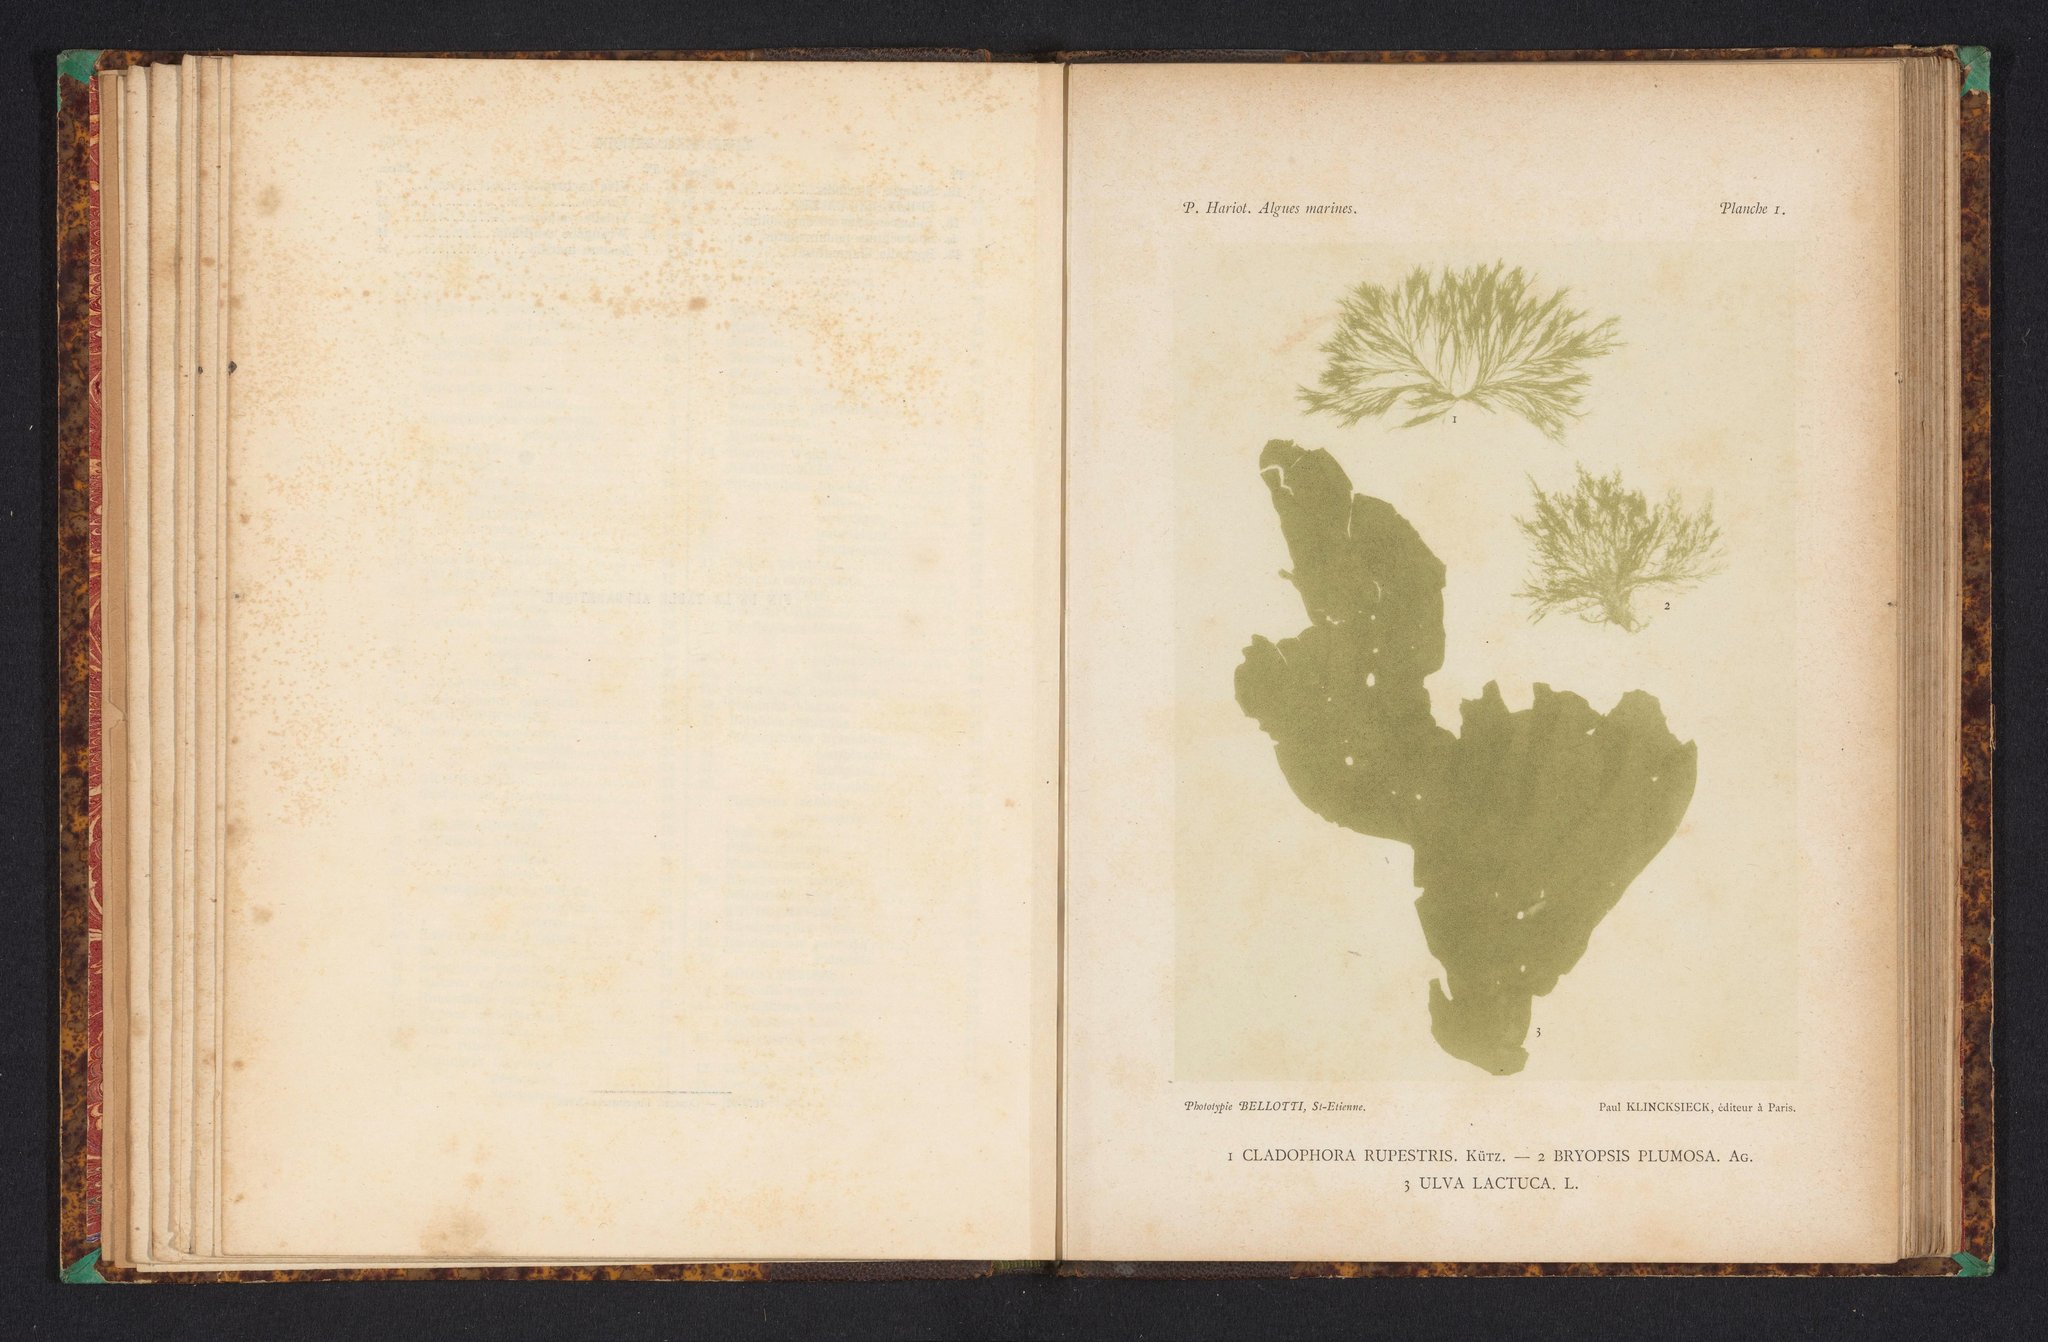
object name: page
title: Drie soorten zeewier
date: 1882-1892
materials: paper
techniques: photograph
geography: france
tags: algae, seaweed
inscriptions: inscription: ‘Cladophora Rupestris (...) Ulva Lactuca. L.’, number: ‘Planche 1.’, number: ‘1 (...) 3’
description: (1) is rotswier, (2) is vederwier, (3) is zeesla.